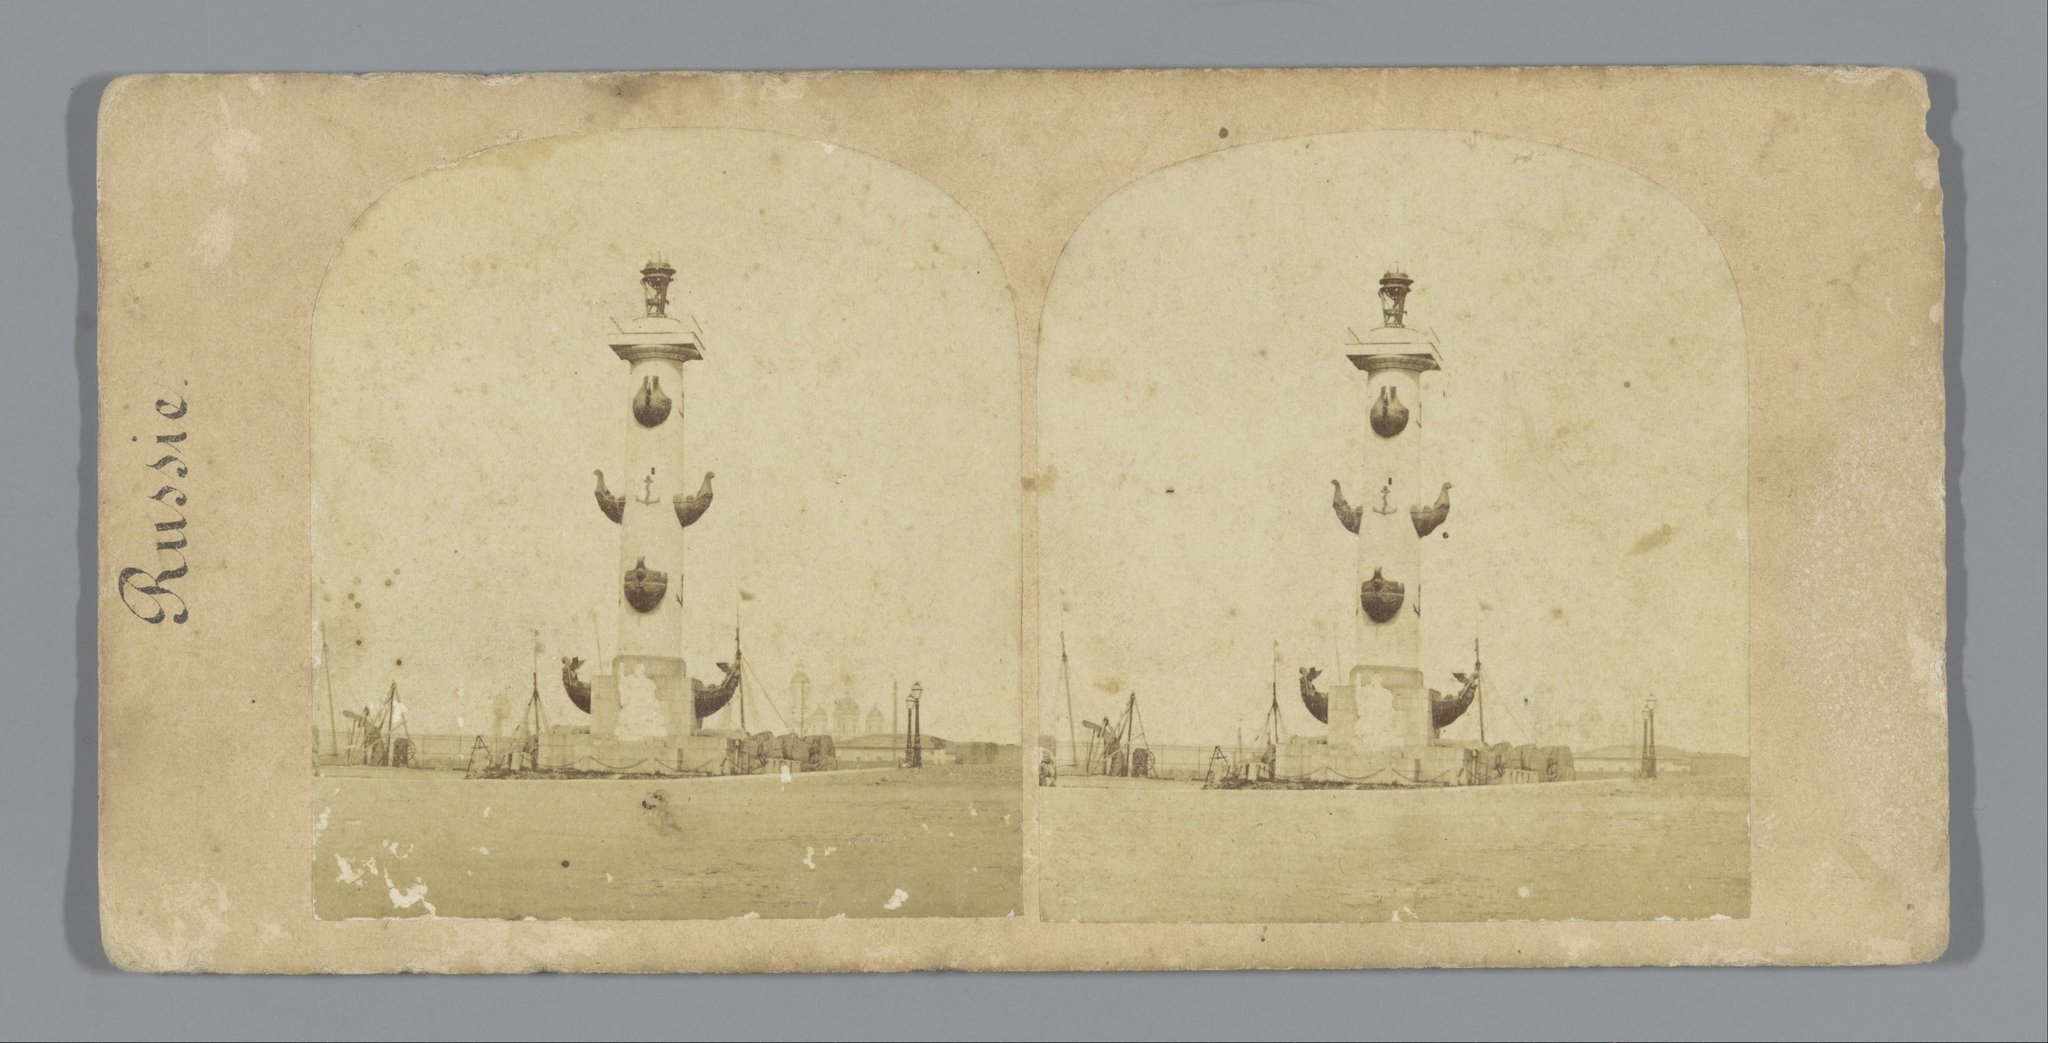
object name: stereograph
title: Vuurtoren in Sint-Petersburg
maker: Anonymous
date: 1850-1880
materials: cardboard, photographic support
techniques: albumen print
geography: sint-petersburg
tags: lighthouse, lightship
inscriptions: inscription: ‘No. 24. Le Phare, St. Petersbourg’, inscription: ‘Russie.’